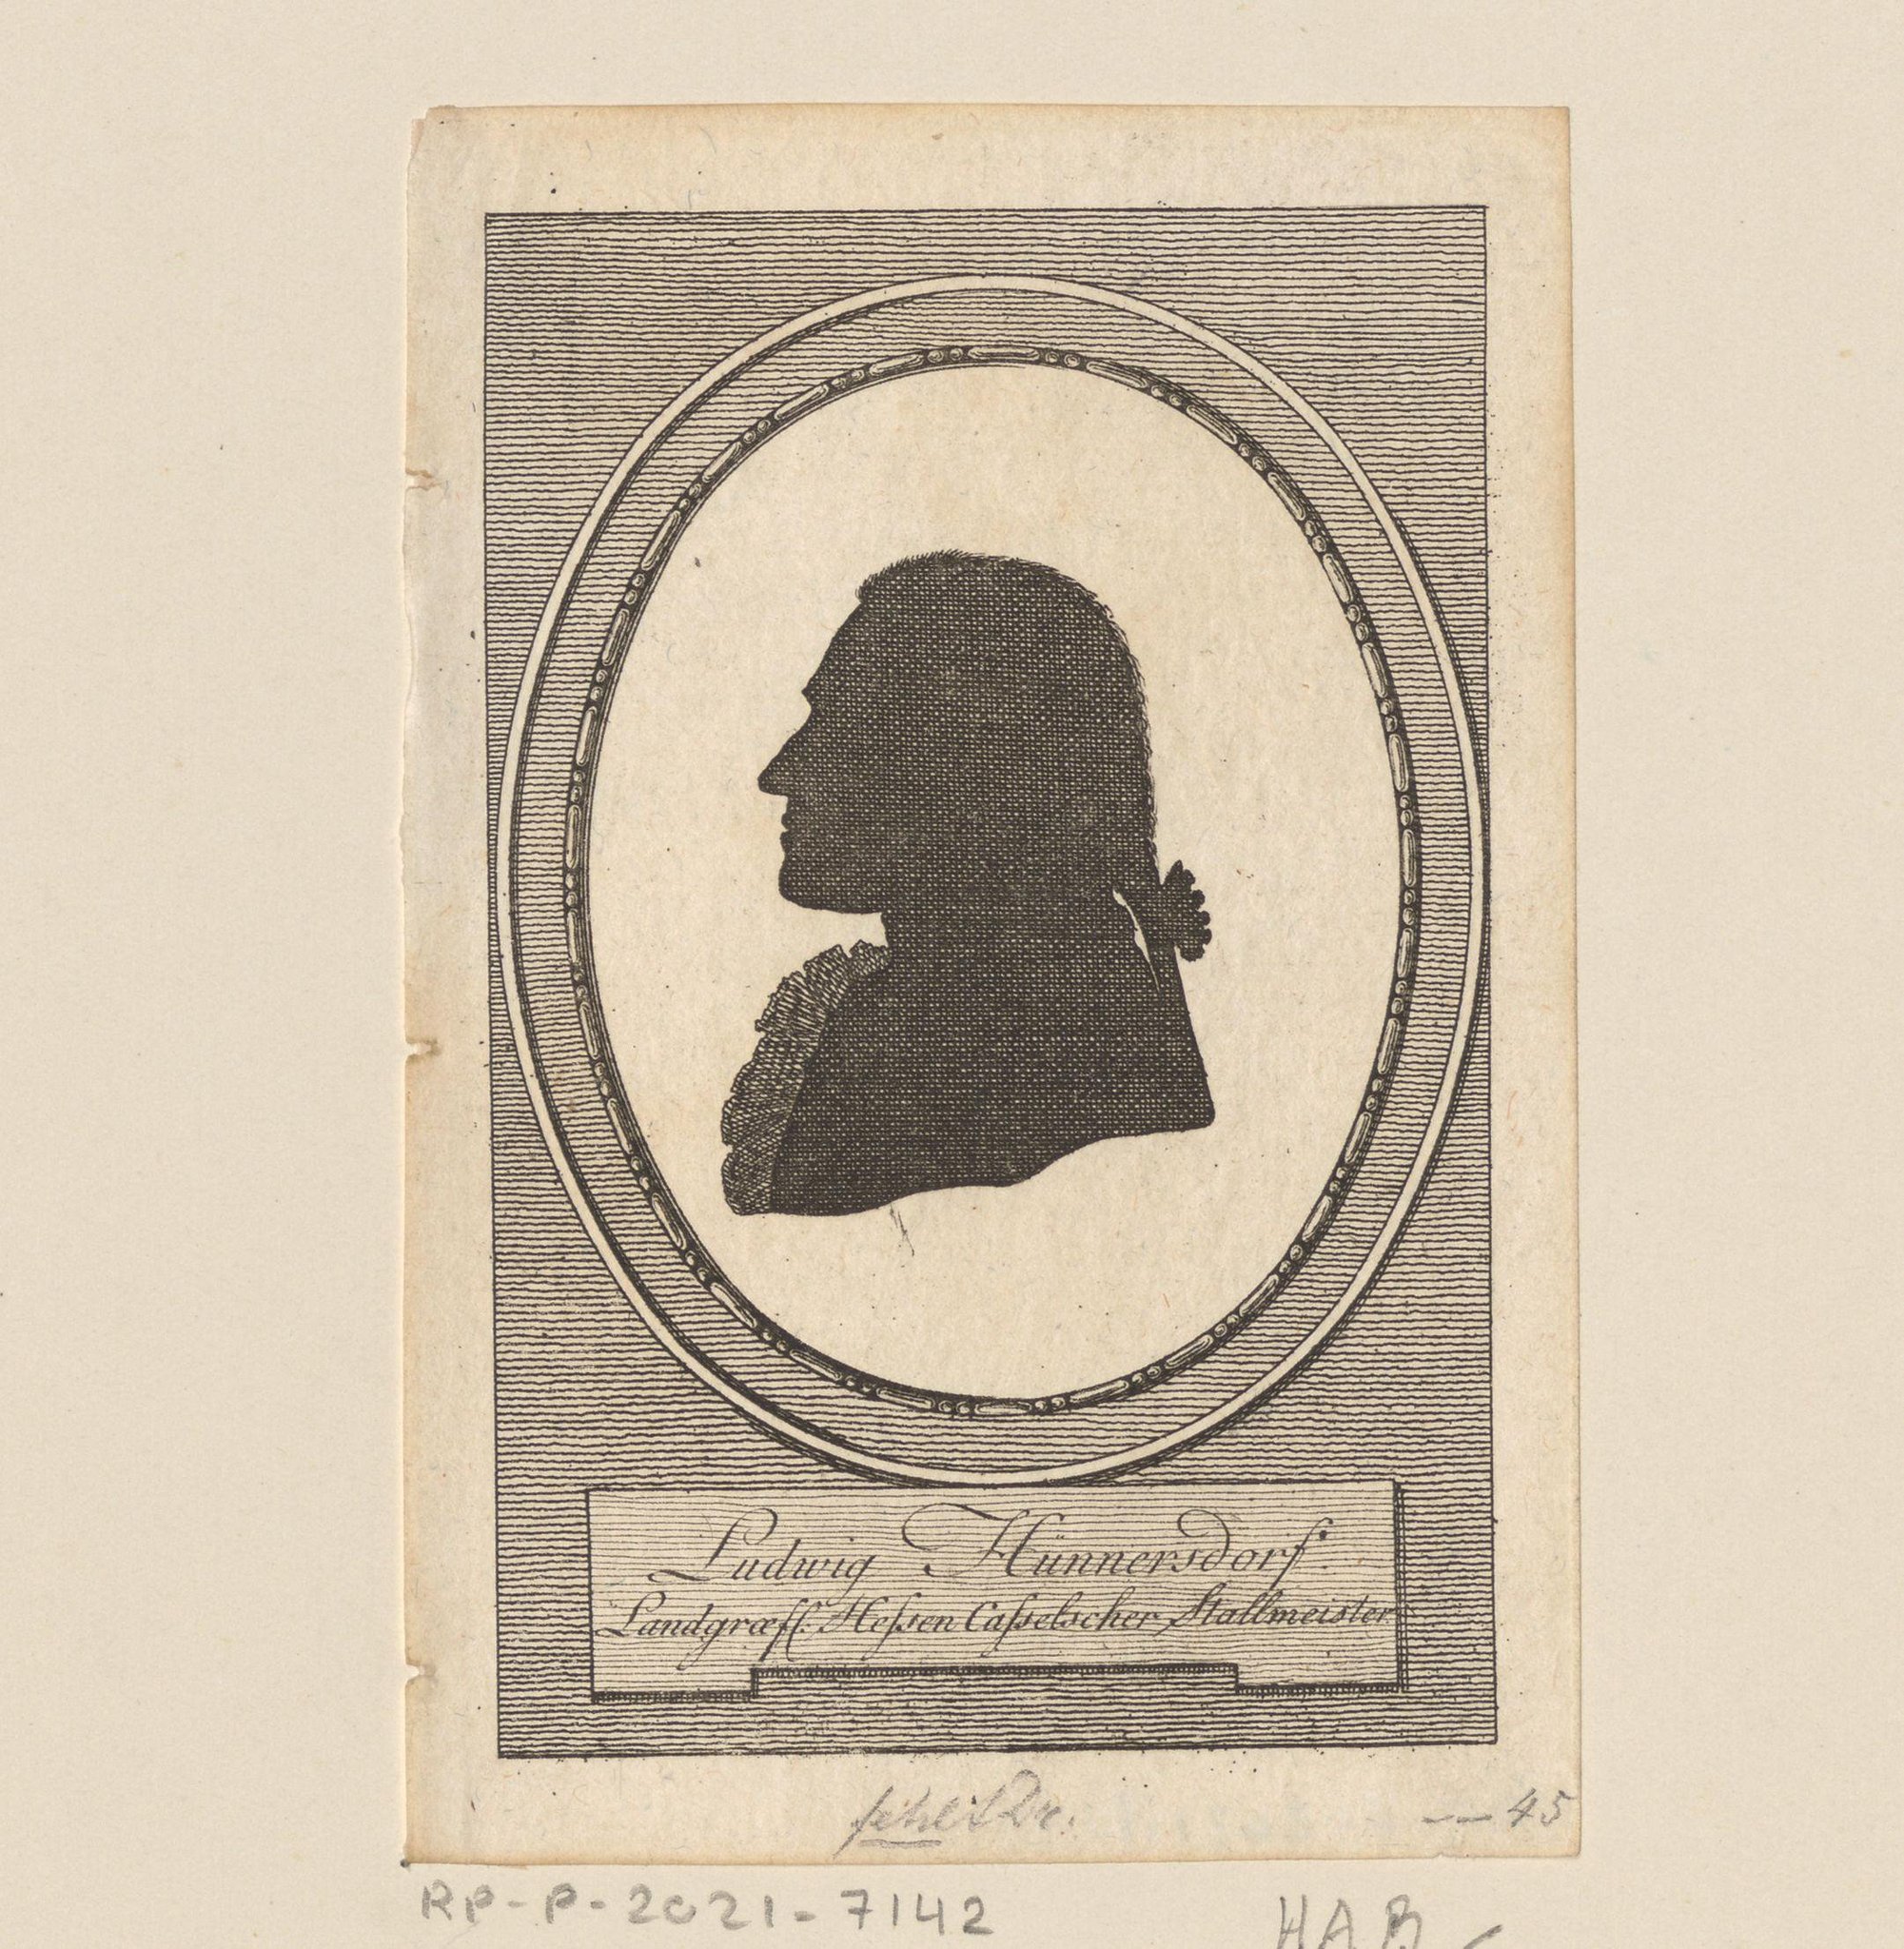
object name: print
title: Silhouetportret van Ludwig Hünersdorf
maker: Anonymous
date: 1776-1799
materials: paper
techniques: etching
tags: historical persons